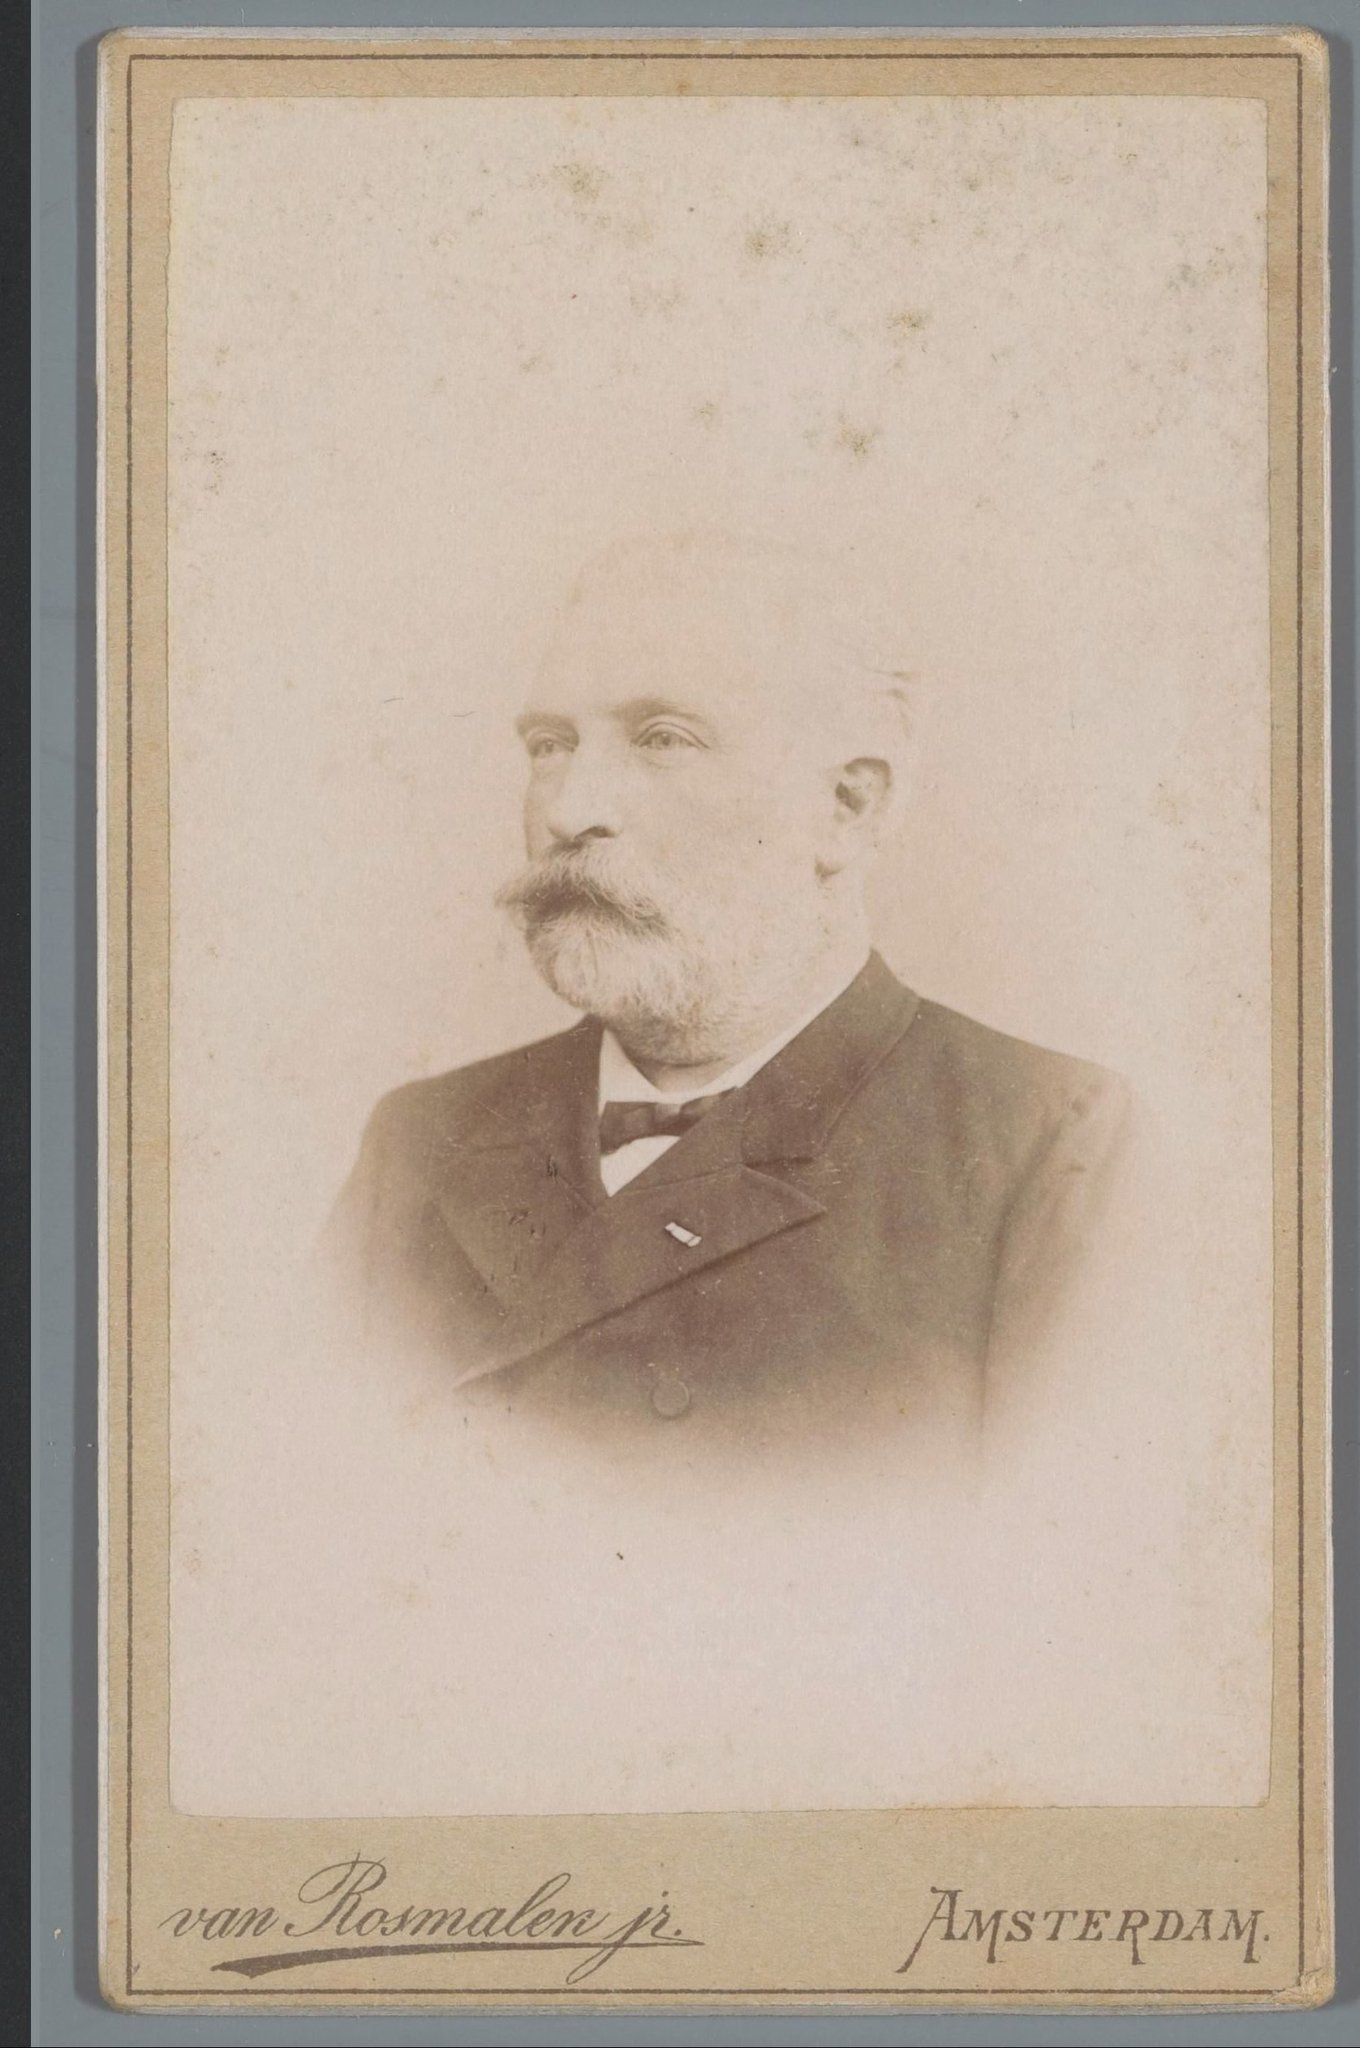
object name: carte de visite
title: Portret van een onbekende man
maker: f.d. van rosmalen jr.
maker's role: fotograaf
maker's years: 1848-1891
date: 1888-1891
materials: cardboard, photographic support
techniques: collodion silver print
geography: amsterdam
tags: adult man, historical persons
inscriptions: inscription: ‘F. D. VAN ROSMALEN JR./ Photograph/ AMSTERDAM/ Kerkstraat 256,/ direct bij de Vijzelstraat./ Vergrootingen in/ onveranderlijke Kooldruk.’